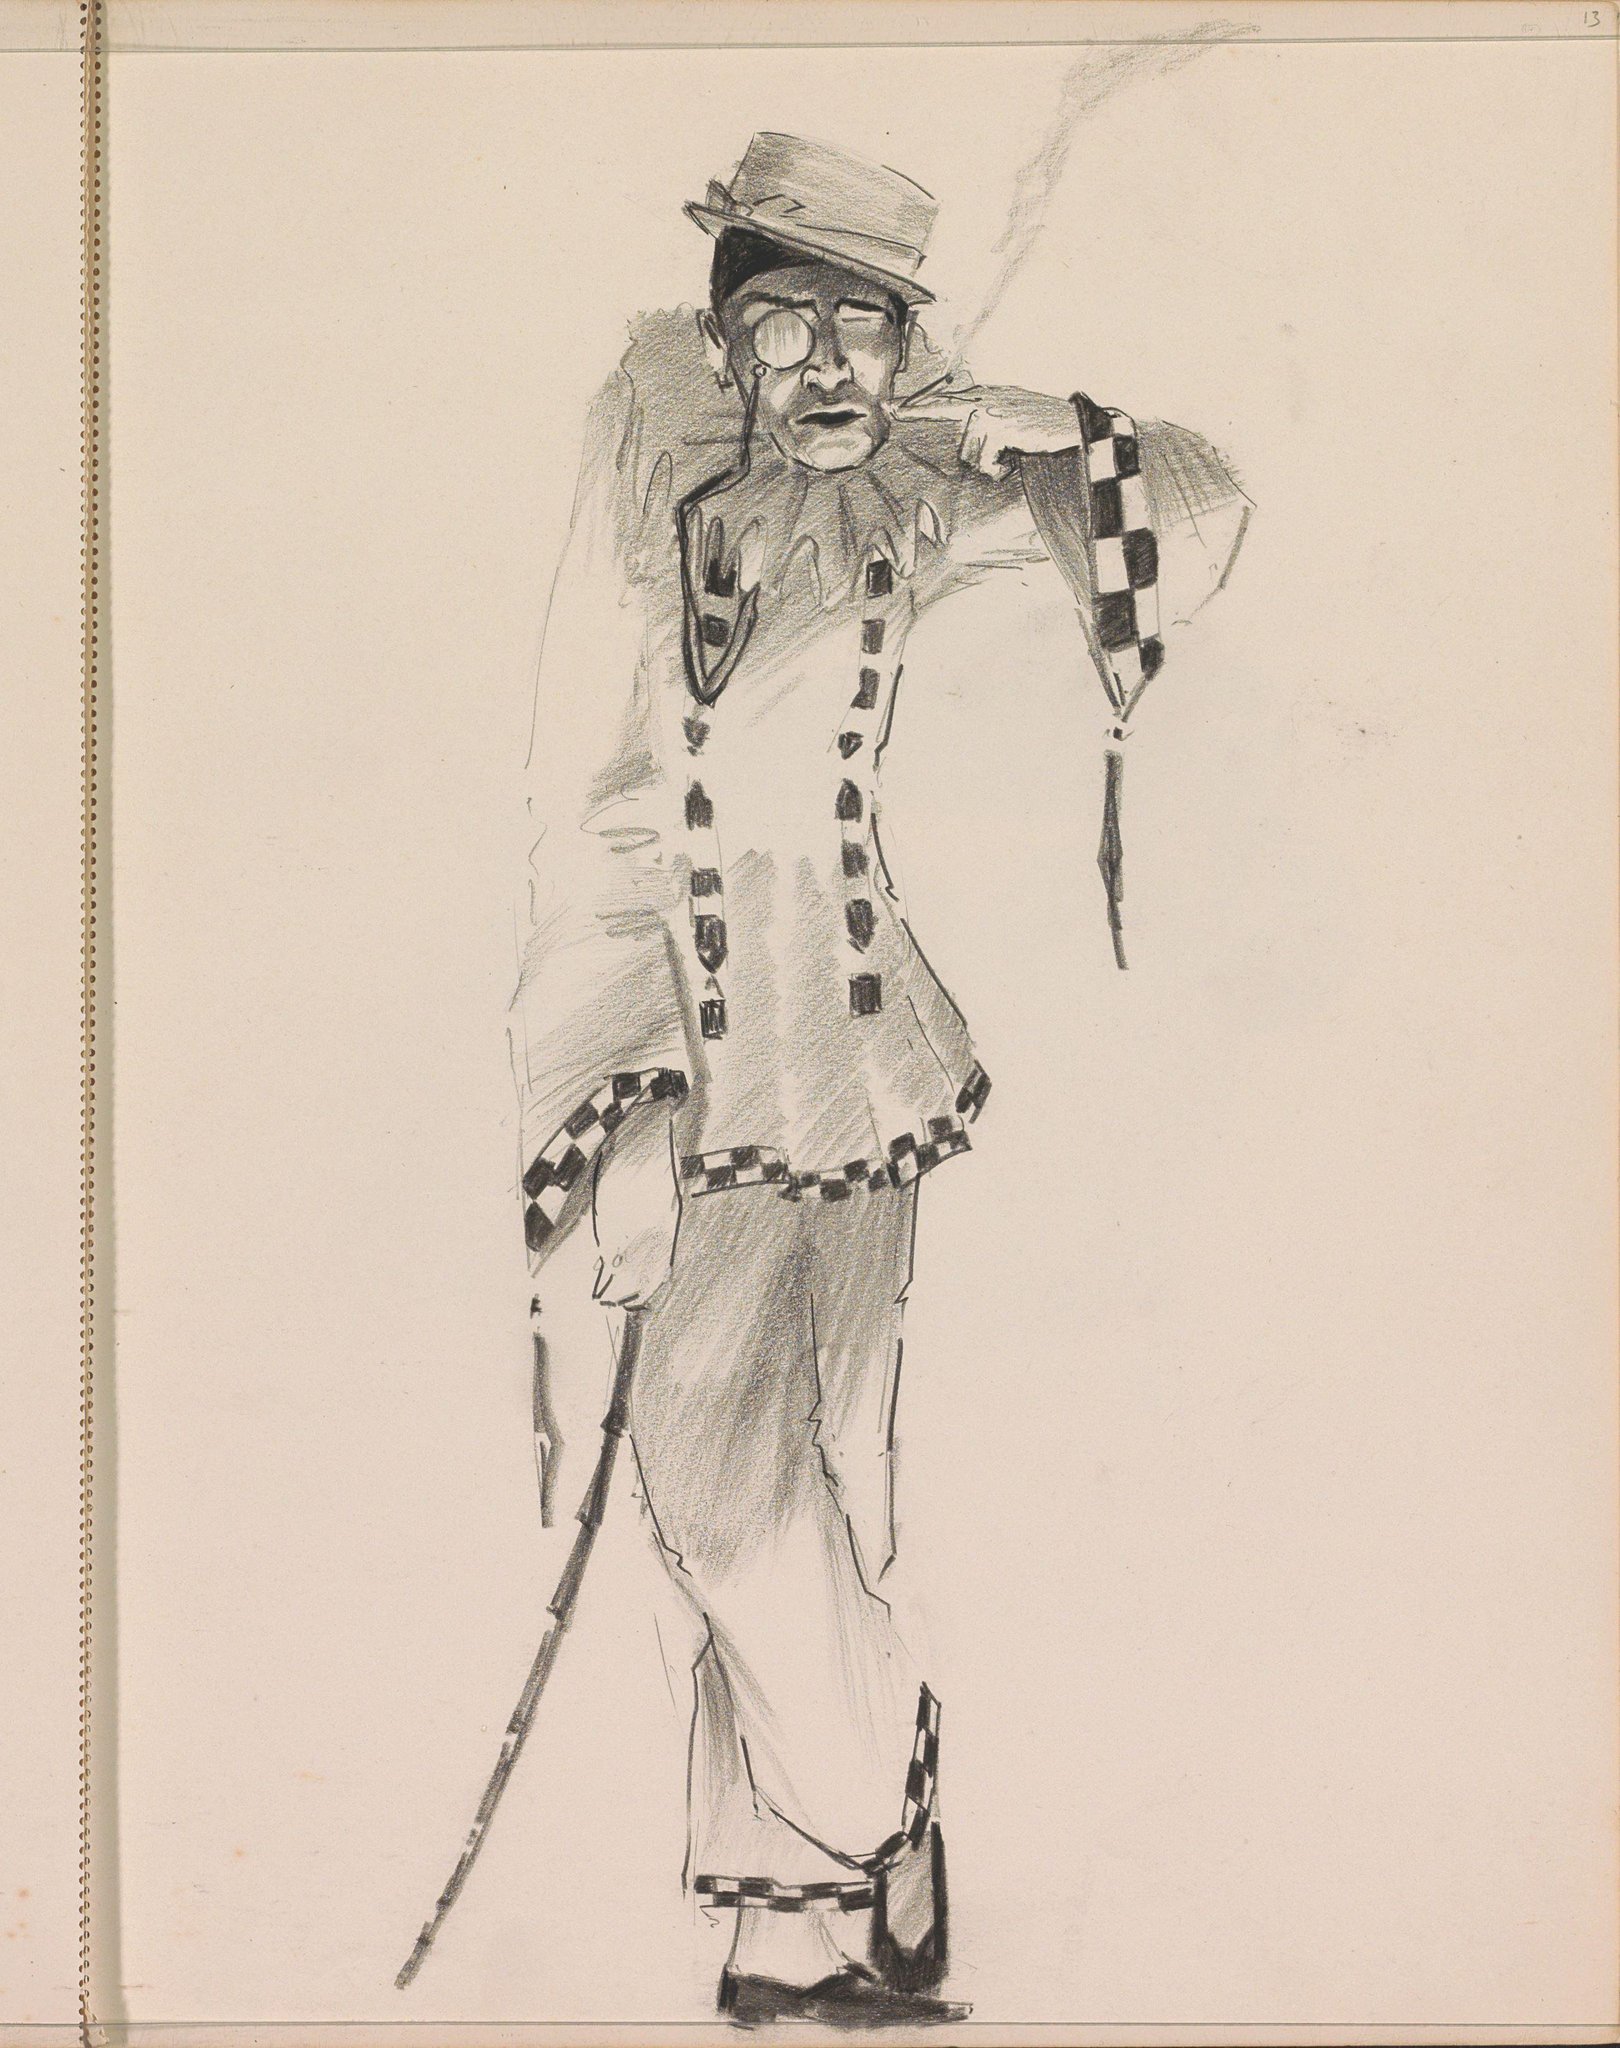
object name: sketchbook leaf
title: Pierrot met een monocle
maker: otto verhagen (i)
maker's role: draughtsman, print maker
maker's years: 1885-1951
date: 1917-1919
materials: charcoal, paper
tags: types in 'commedia dell'arte': pierrot, cigarette, monocle, single lorgnette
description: De pierrot heet een brandende sigaret tussen de vingers van zijn linkerhand. Met de rechterhand houdt hij een stok vast waarmee hij op de grond leunt. Pagina 13 uit een schetsboek met 28 bladen.